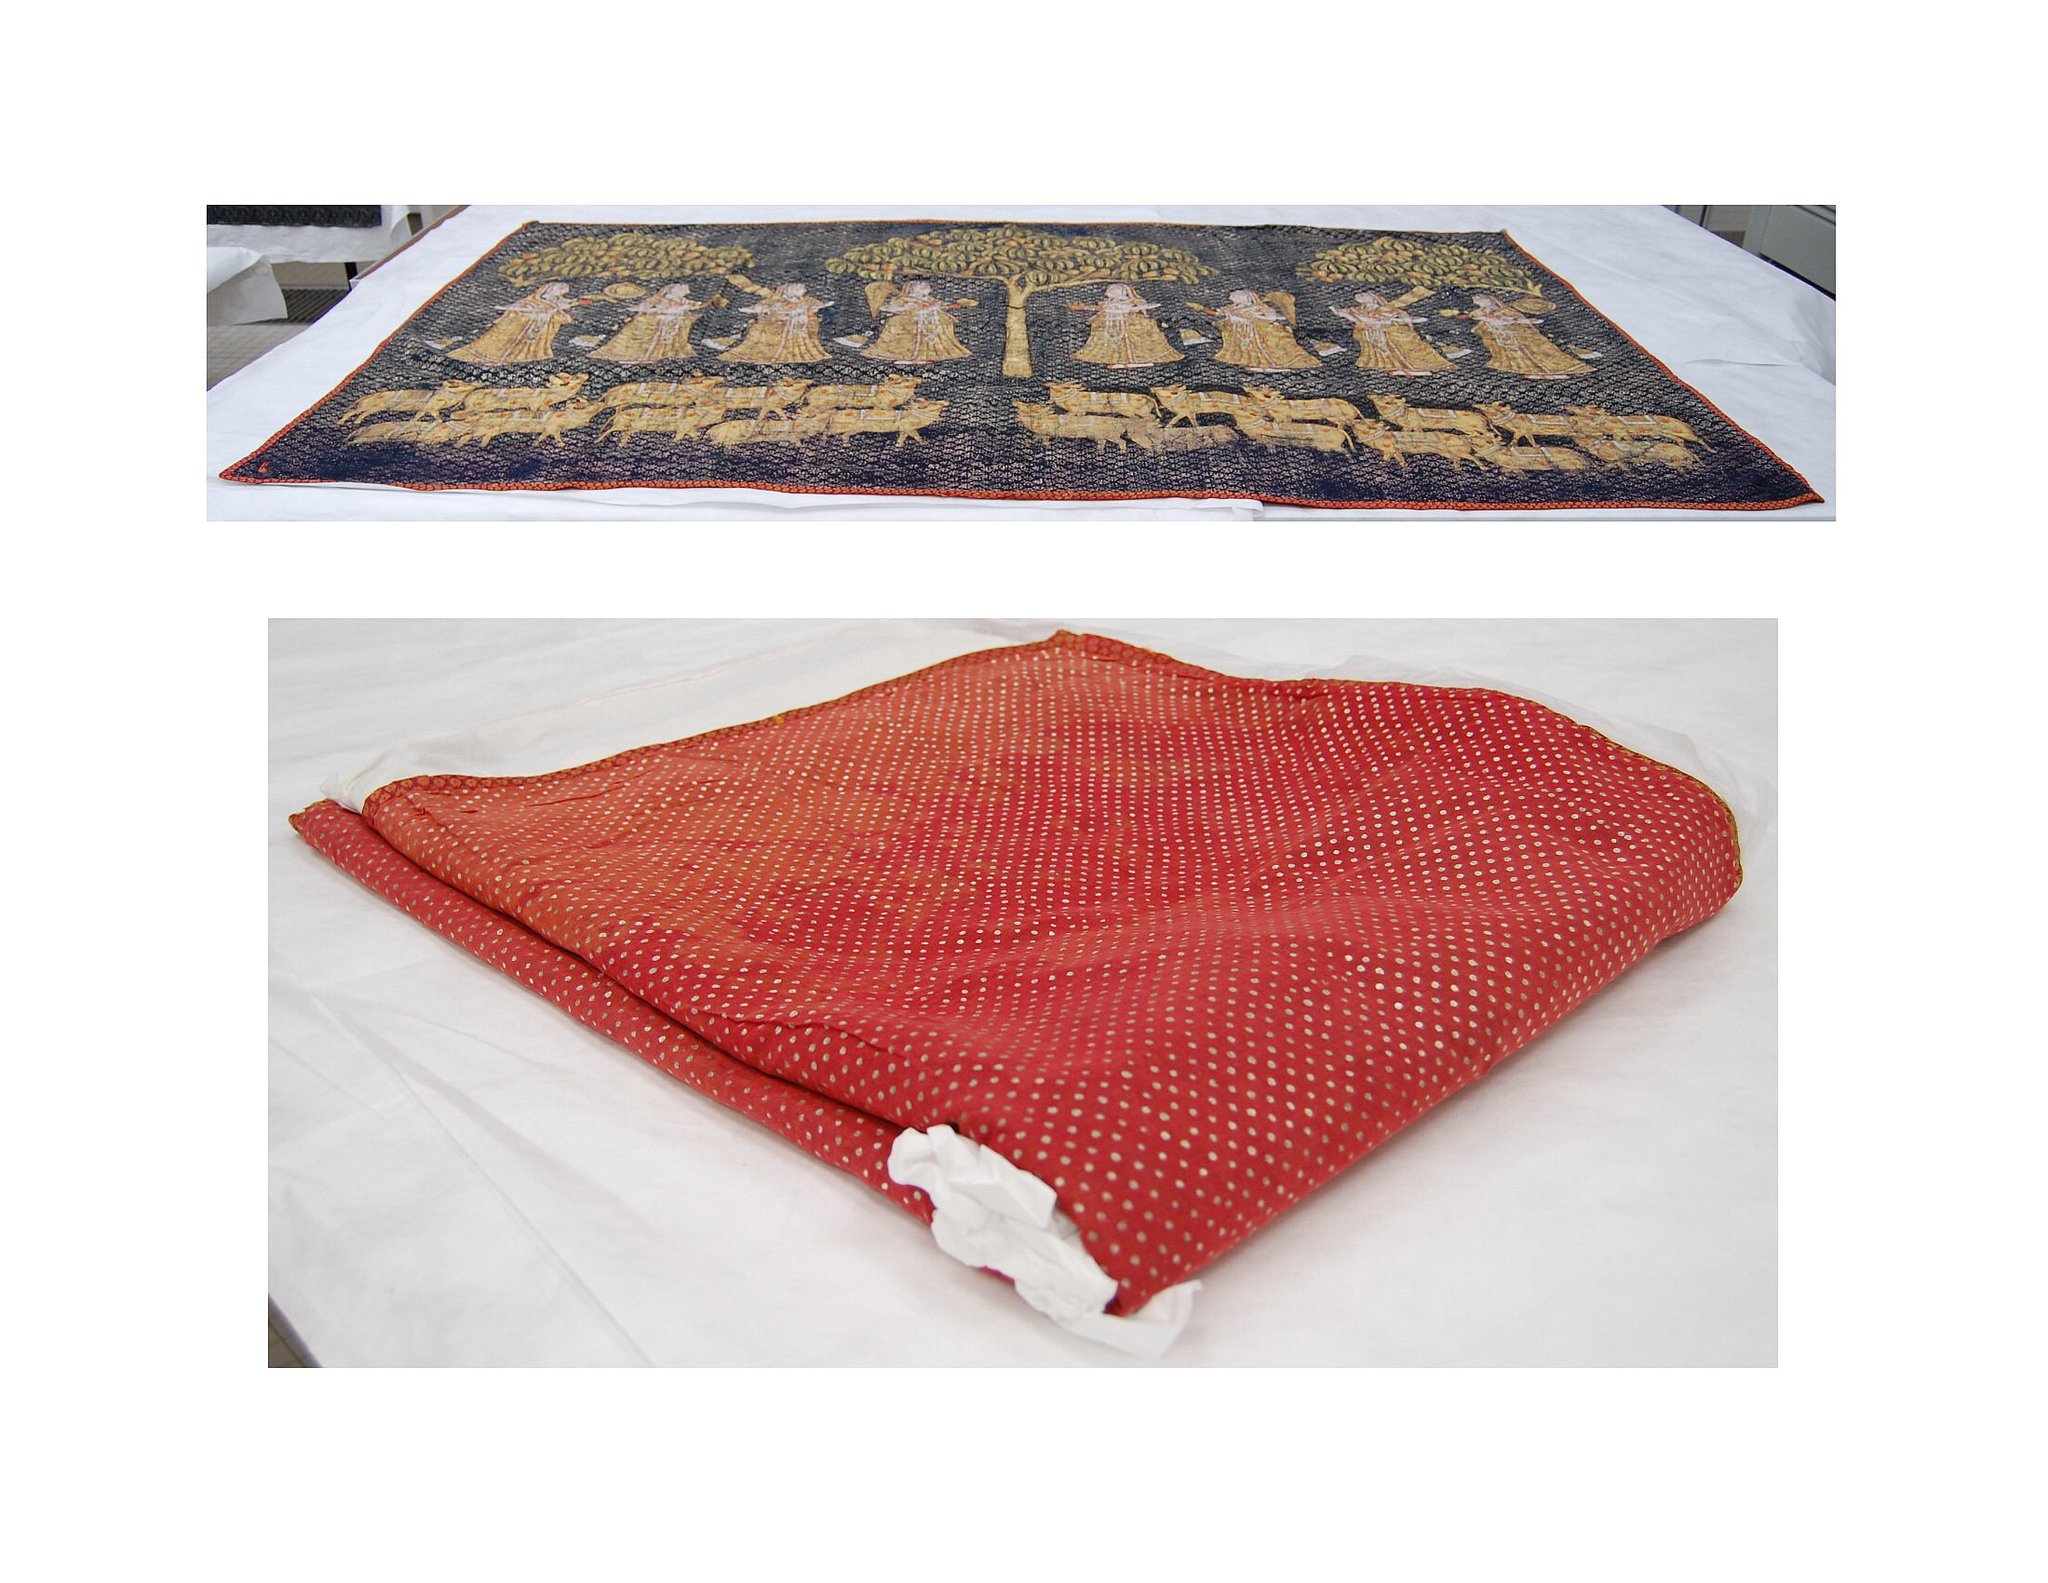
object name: hanging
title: Hanging (Pichwai)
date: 1767-1800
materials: cotton, gold leaf, pigment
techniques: dyeing, painting, weave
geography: india